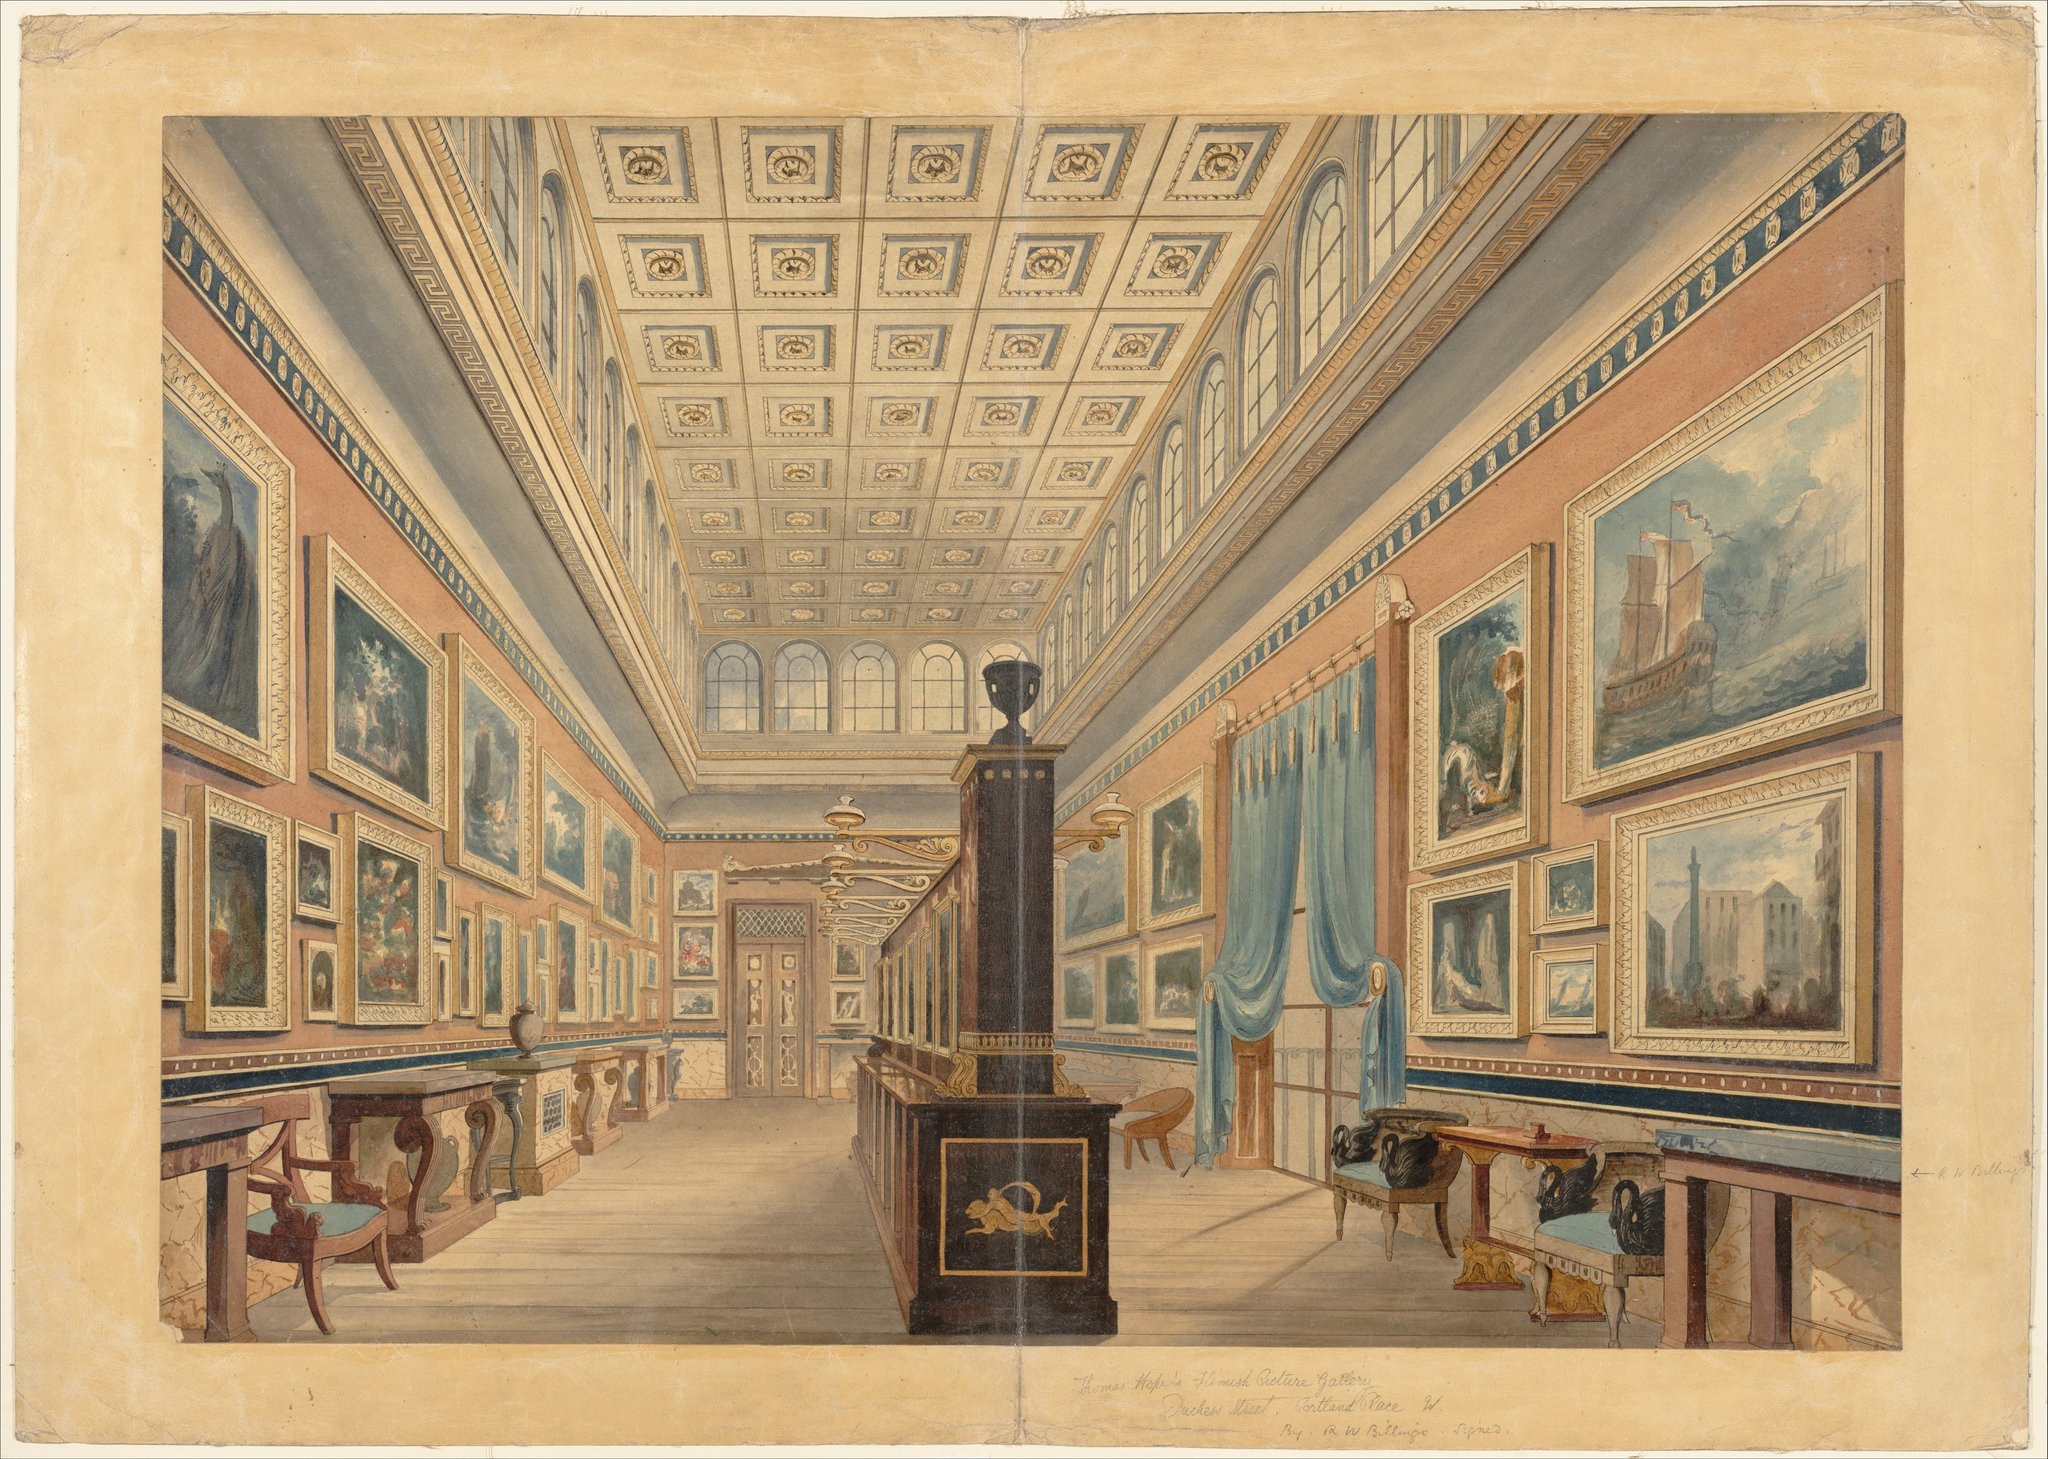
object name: drawing ornament architecture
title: The Flemish Picture Gallery, the Mansion of Thomas Hope, Duchess Street, Portland Place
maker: robert william billings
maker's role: artist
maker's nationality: british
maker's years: 1813-1874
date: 1830-1851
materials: watercolor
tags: interiors